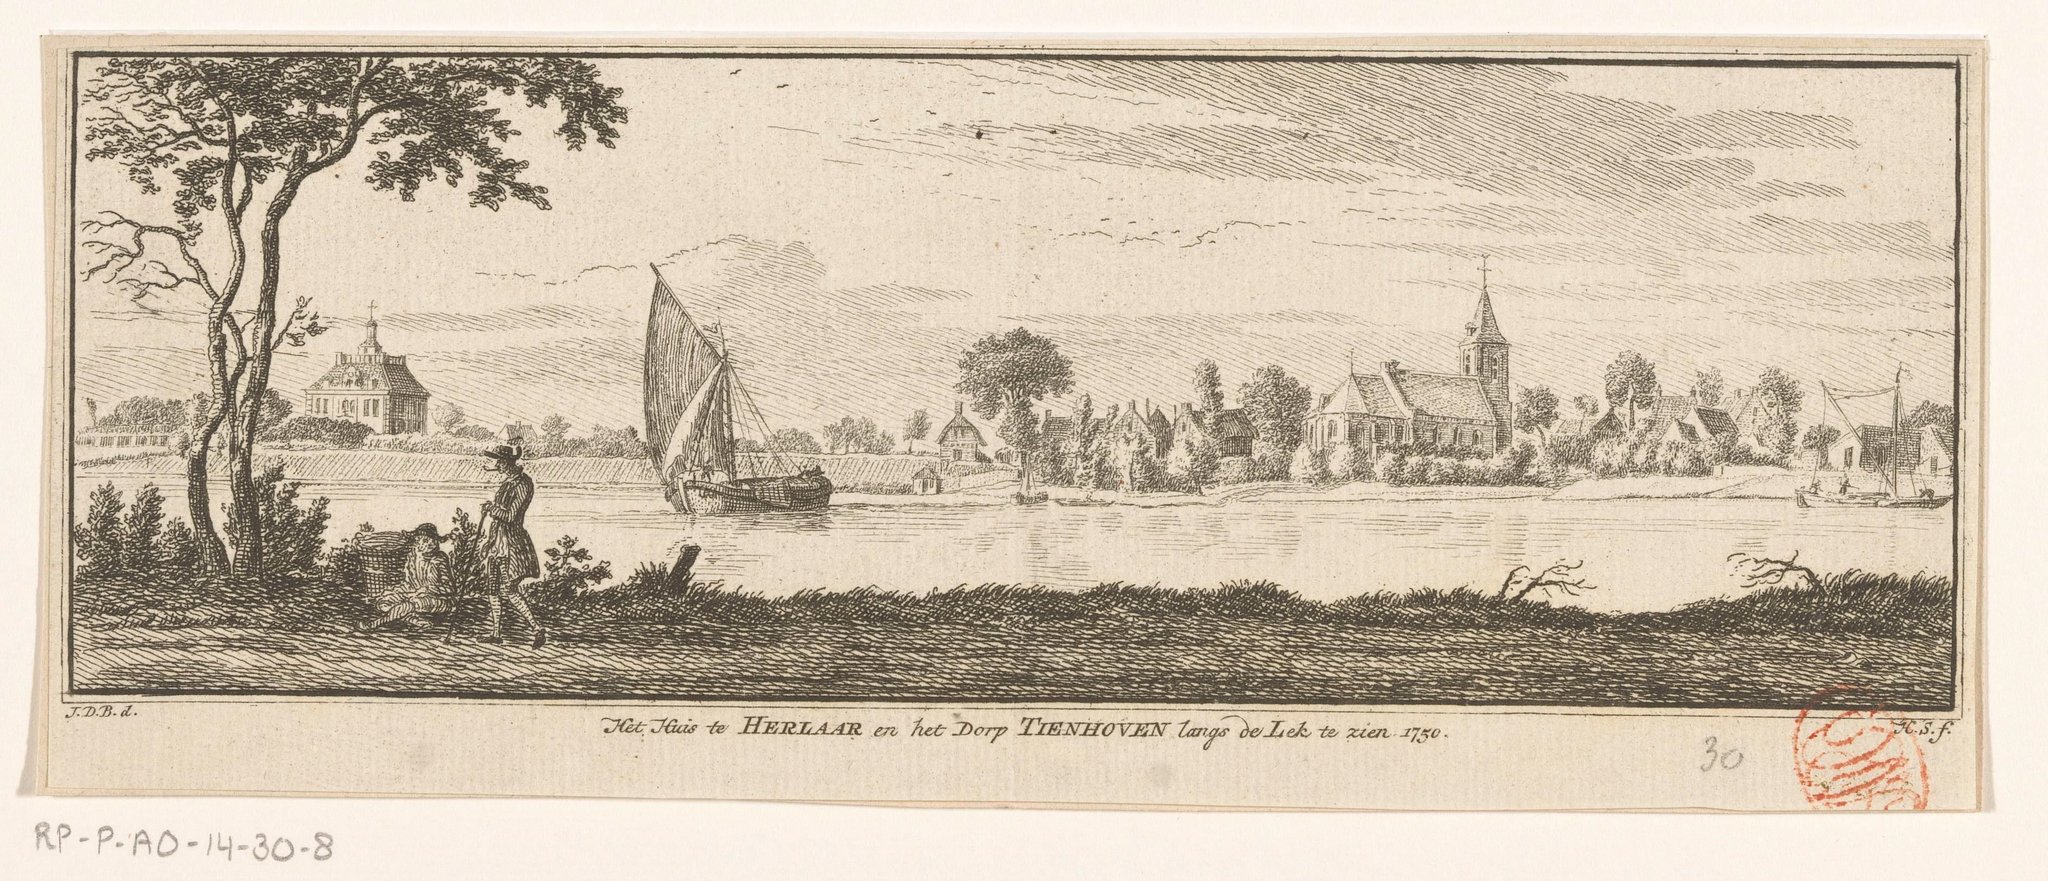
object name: print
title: Het Huis te Herlaar en het dorp Tienhoven langs de Lek te zien. 1750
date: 1757-1792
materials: paper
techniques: etching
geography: haarlem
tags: prospect of village, silhouette of village, sailing-ship, sailing-boat, castle, church (exterior)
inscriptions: collector's mark: Lugt 195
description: Oorspronkelijk van één plaat gedrukt met RP-P-AO-14-30-7. Hele prent ook gebruikt in: Het verheerlykt Nederland of kabinet van hedendaagsche gezigten van steden, dorpen (…). 9 delen. Amsterdam: Isaak Tirion en weduwe Isaak Tirion, 1745-1774, dl. 6 (1757), ill. 483-484. Of in: Nederlandsche tafereelen; of eene keurige verzameling van negen honderd fraaije gezigten van steden, dorpen, sloten, oudheden (….). 9 delen. Amsterdam: Jan de Groot, 1792, dl. 6, ill. 483-484. Zie RP-T-1888-A-1575 voor de tekening waar deze prent op is gebaseerd.